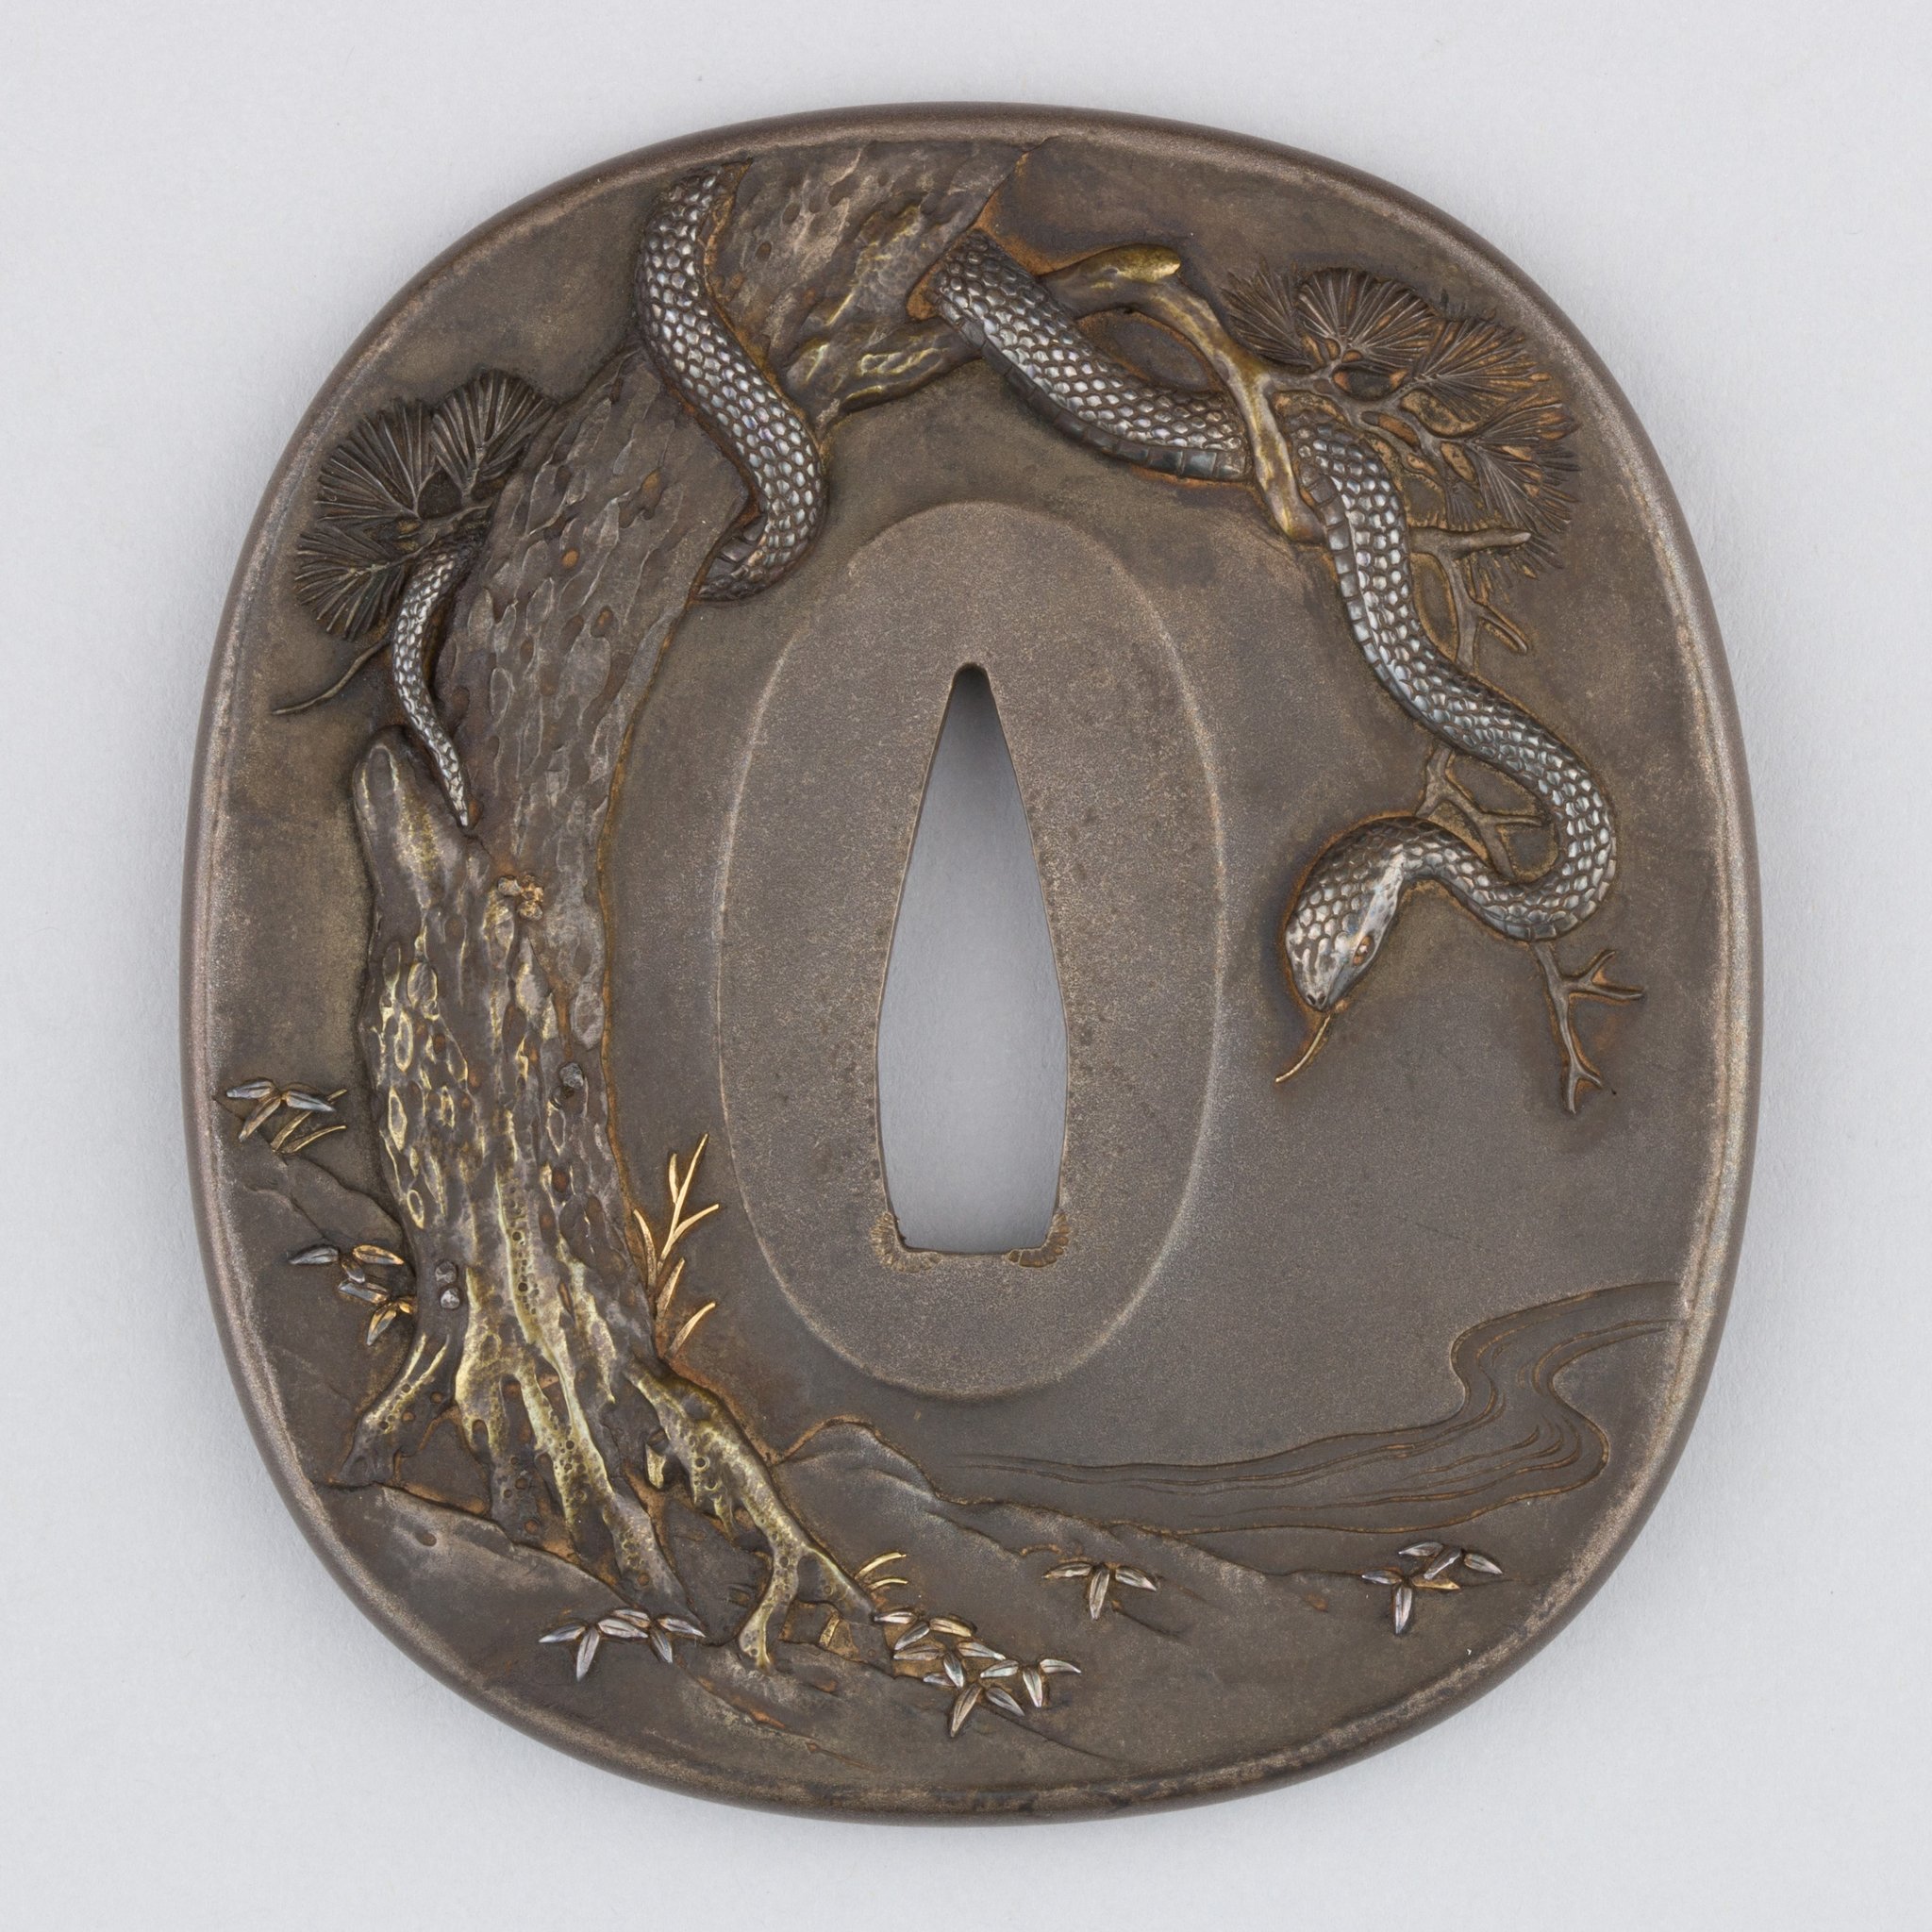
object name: sword guard tsuba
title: Sword Guard (Tsuba)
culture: japanese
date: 1615-1868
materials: copper, gold alloy, silver alloy, gold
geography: japan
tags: snakes,trees